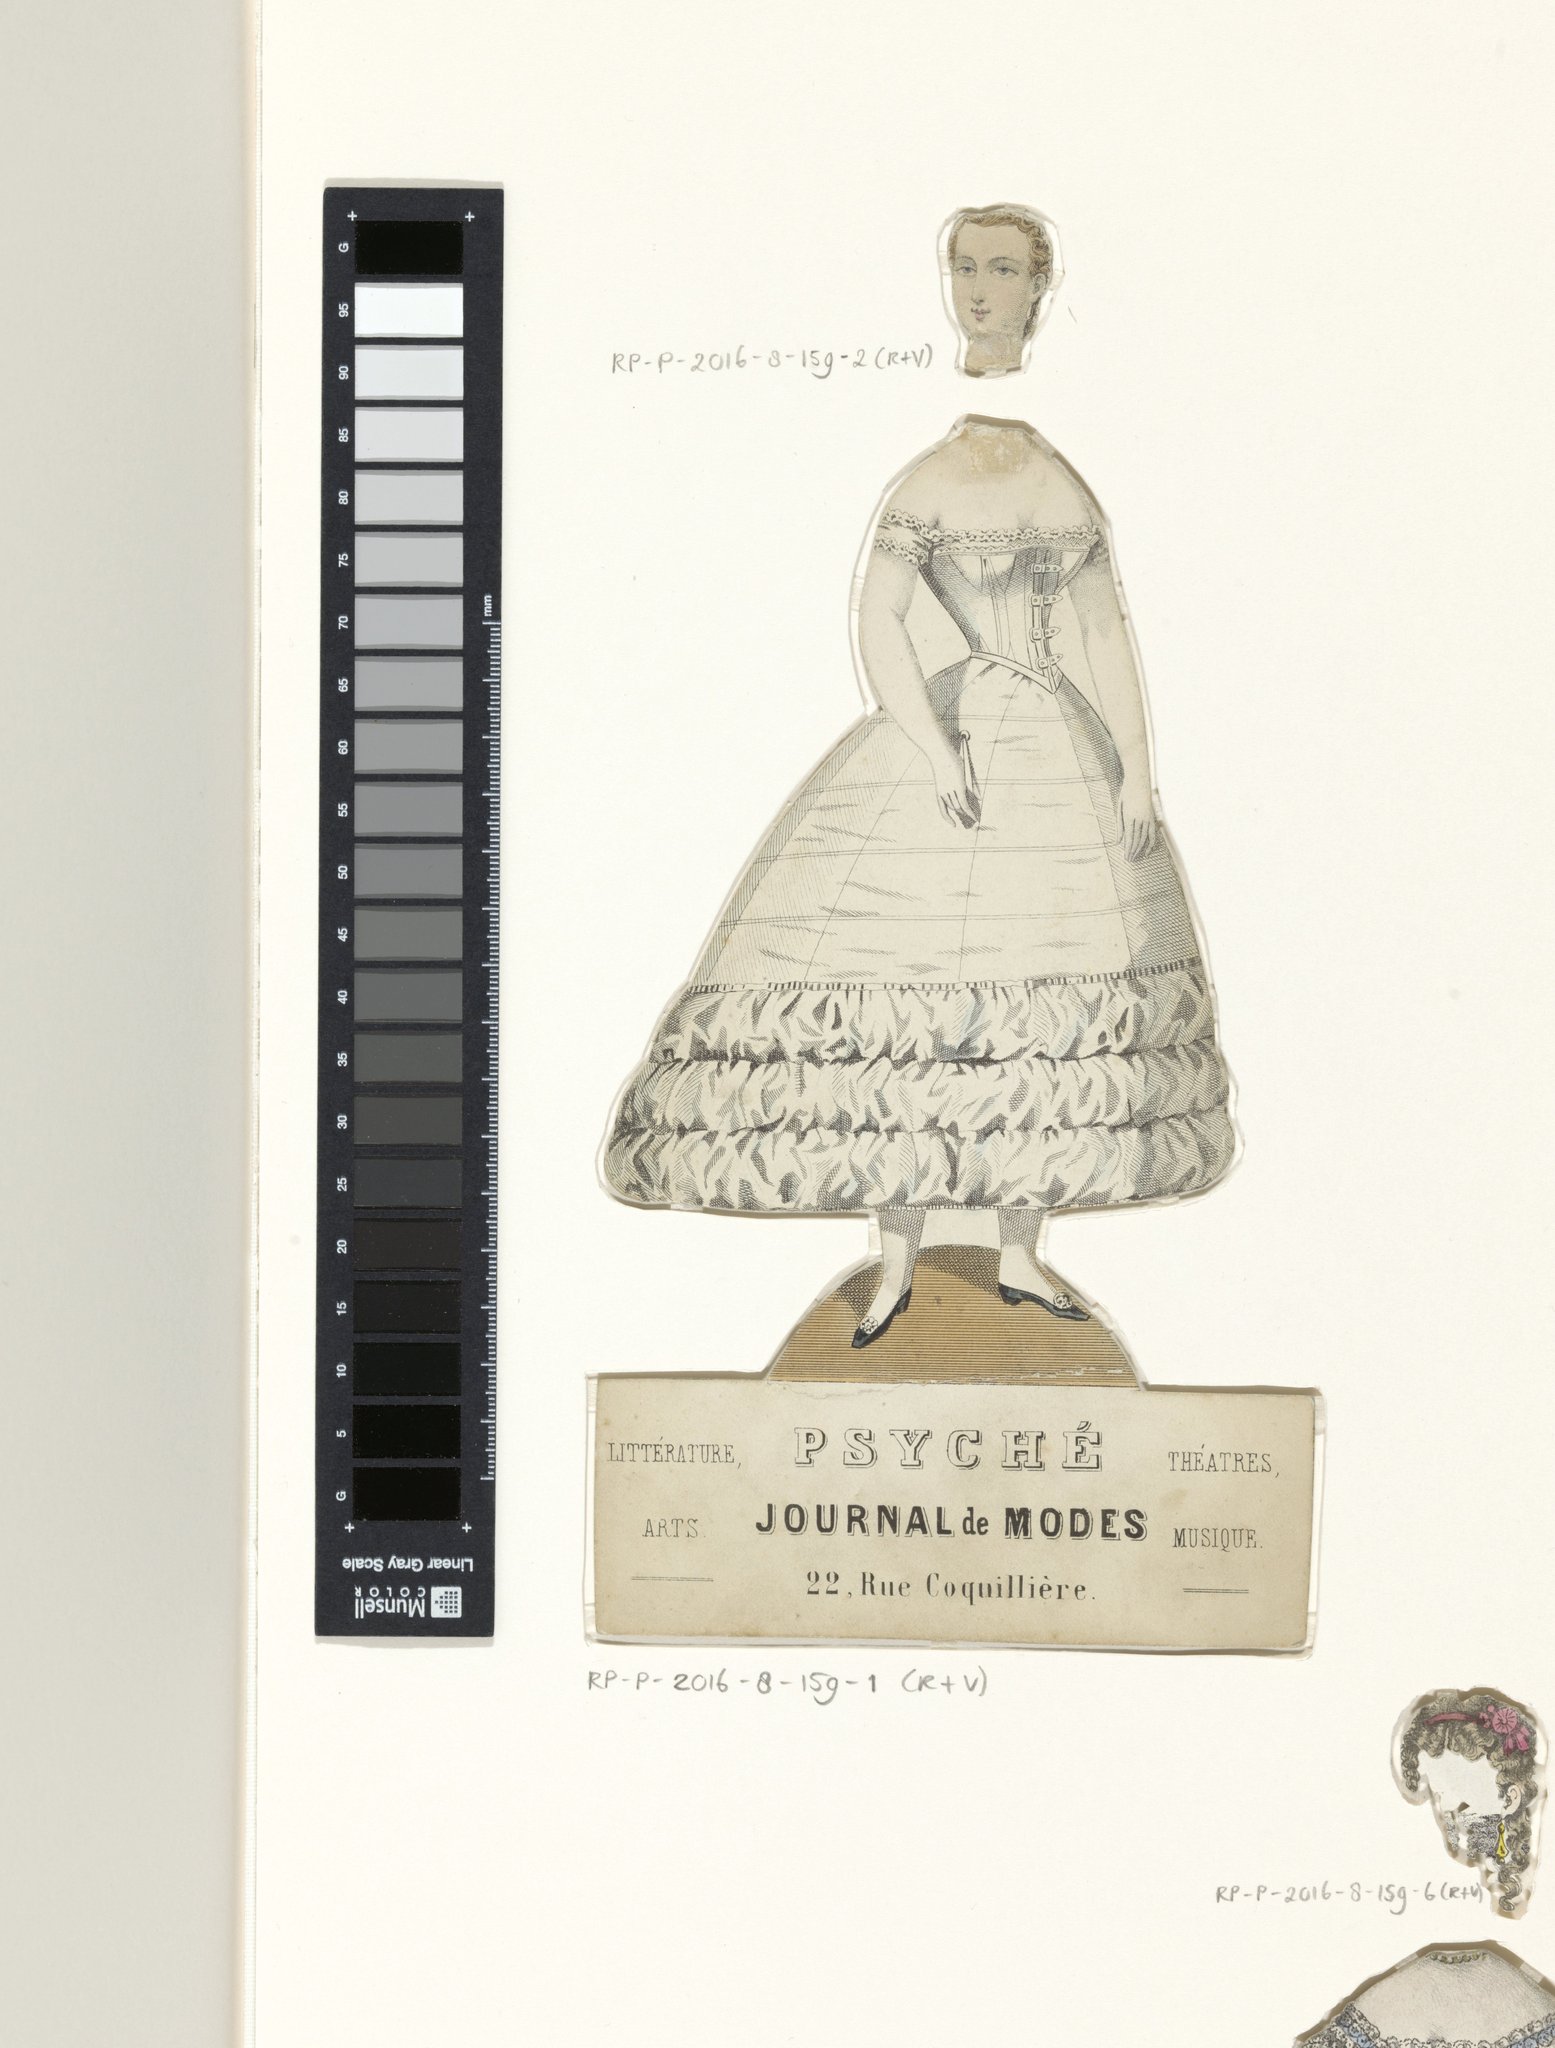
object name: fashion print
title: Uitknippop in onderjurk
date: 1825-1875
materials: paper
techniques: engraving, hand coloring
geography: paris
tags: fashion plates